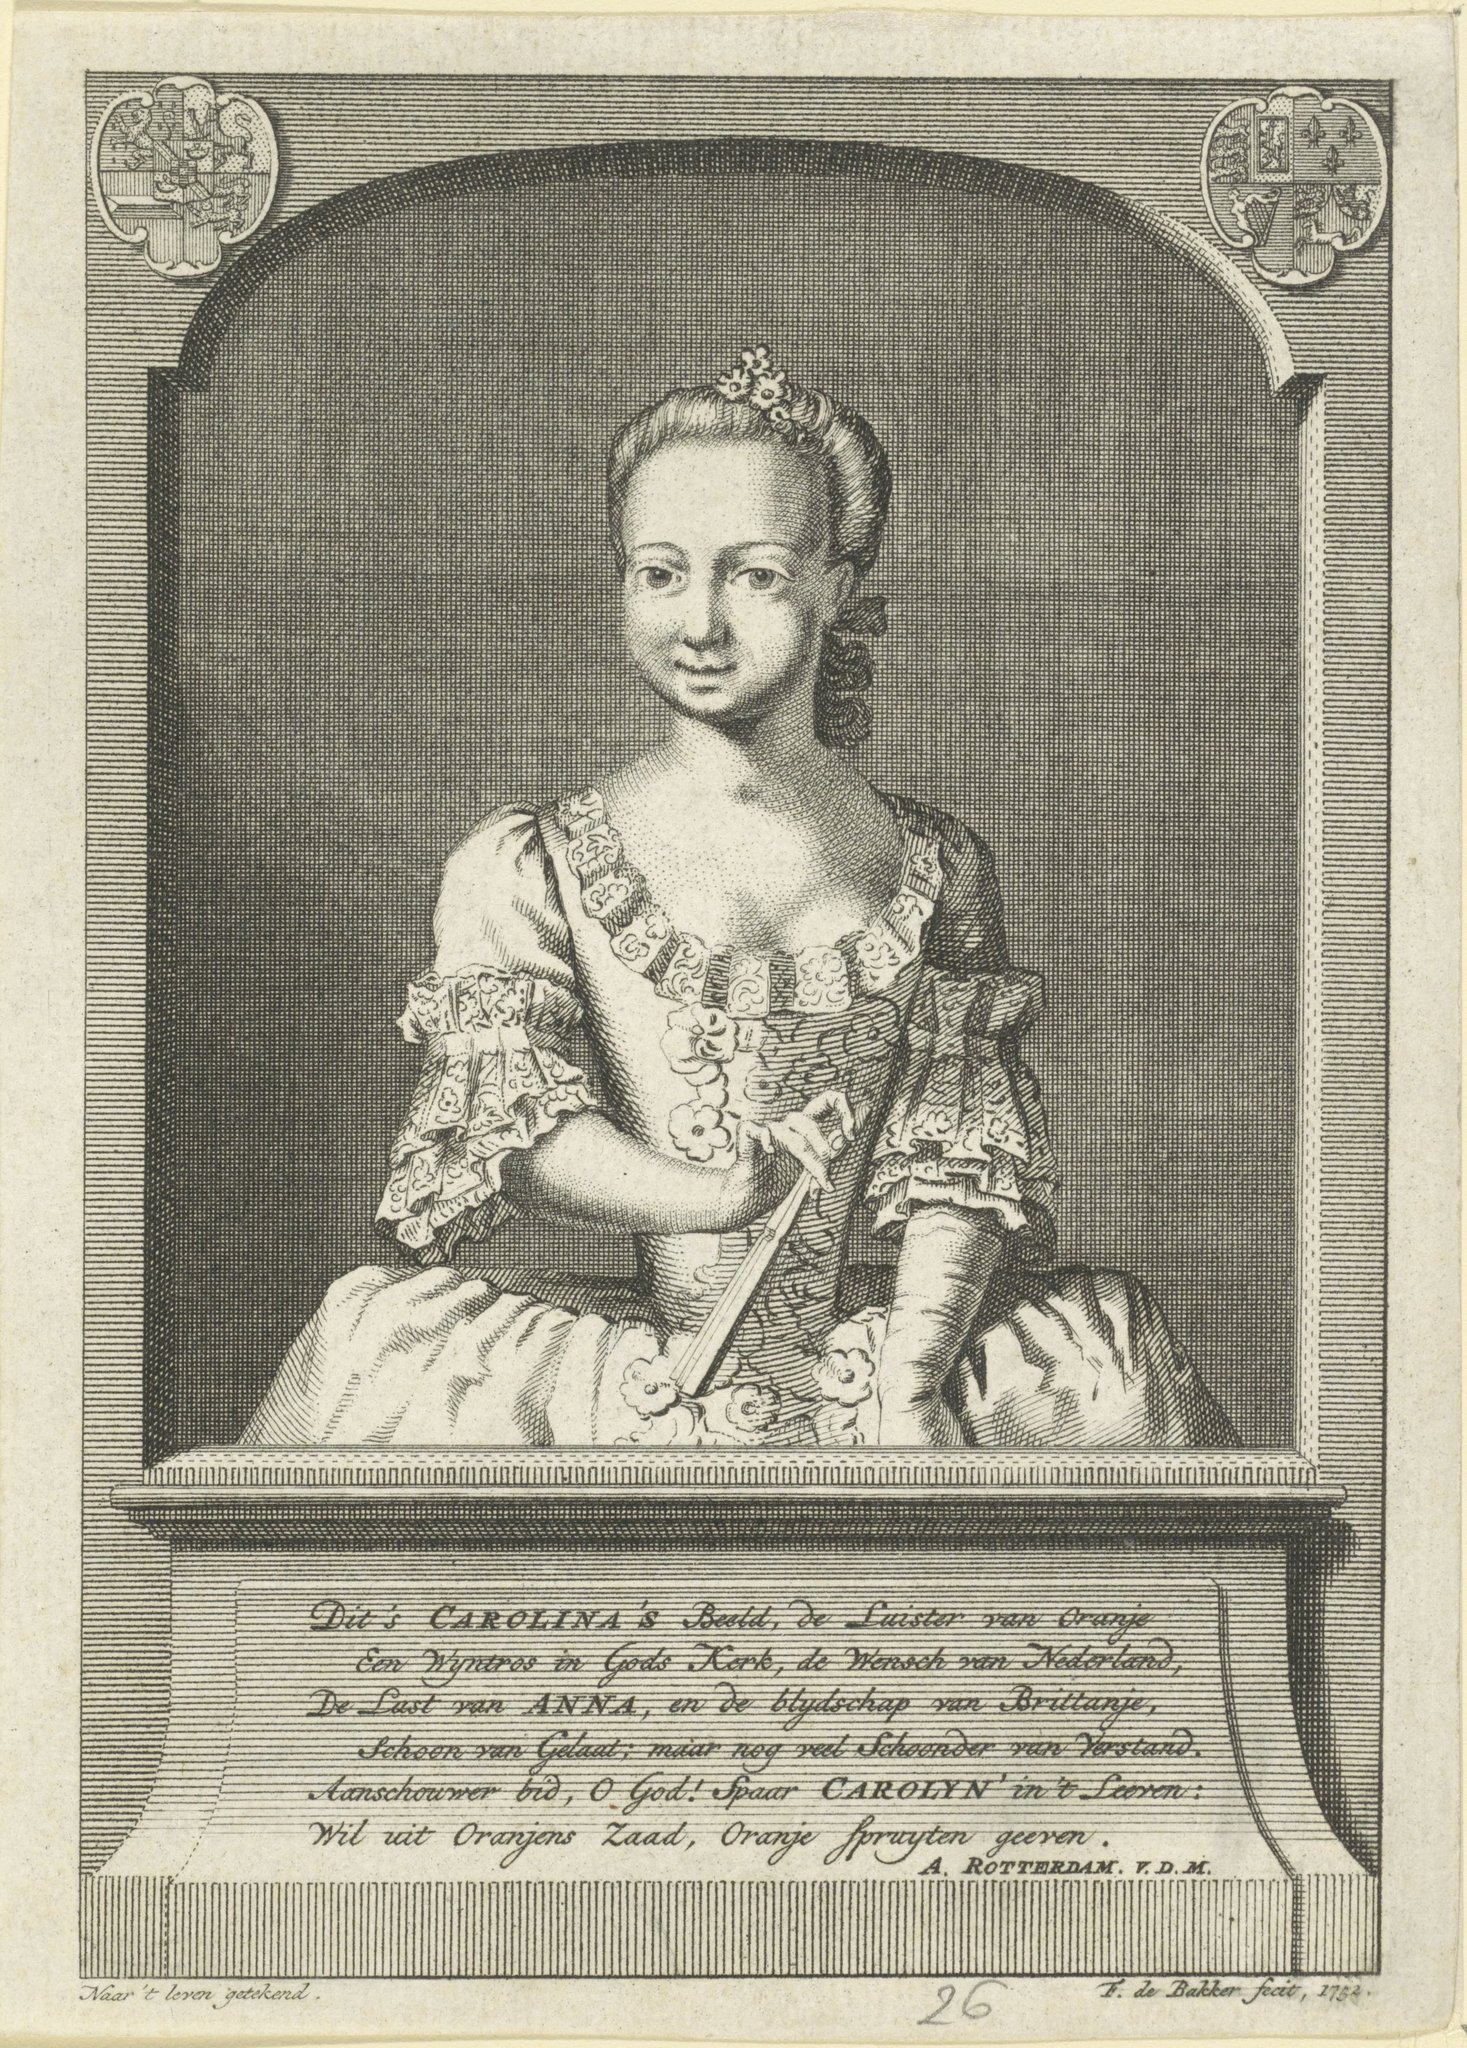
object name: print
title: Portret van Carolina, prinses van Oranje-Nassau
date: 1752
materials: paper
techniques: engraving, etching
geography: amsterdam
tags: carolina (prinses van oranje-nassau)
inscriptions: collector's mark: Lugt 2228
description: De hier vermelde titel verwijst naar de hoogst verkregen titel van de geportretteerde, niet per se naar de titel die de geportretteerde op deze voorstelling draagt.